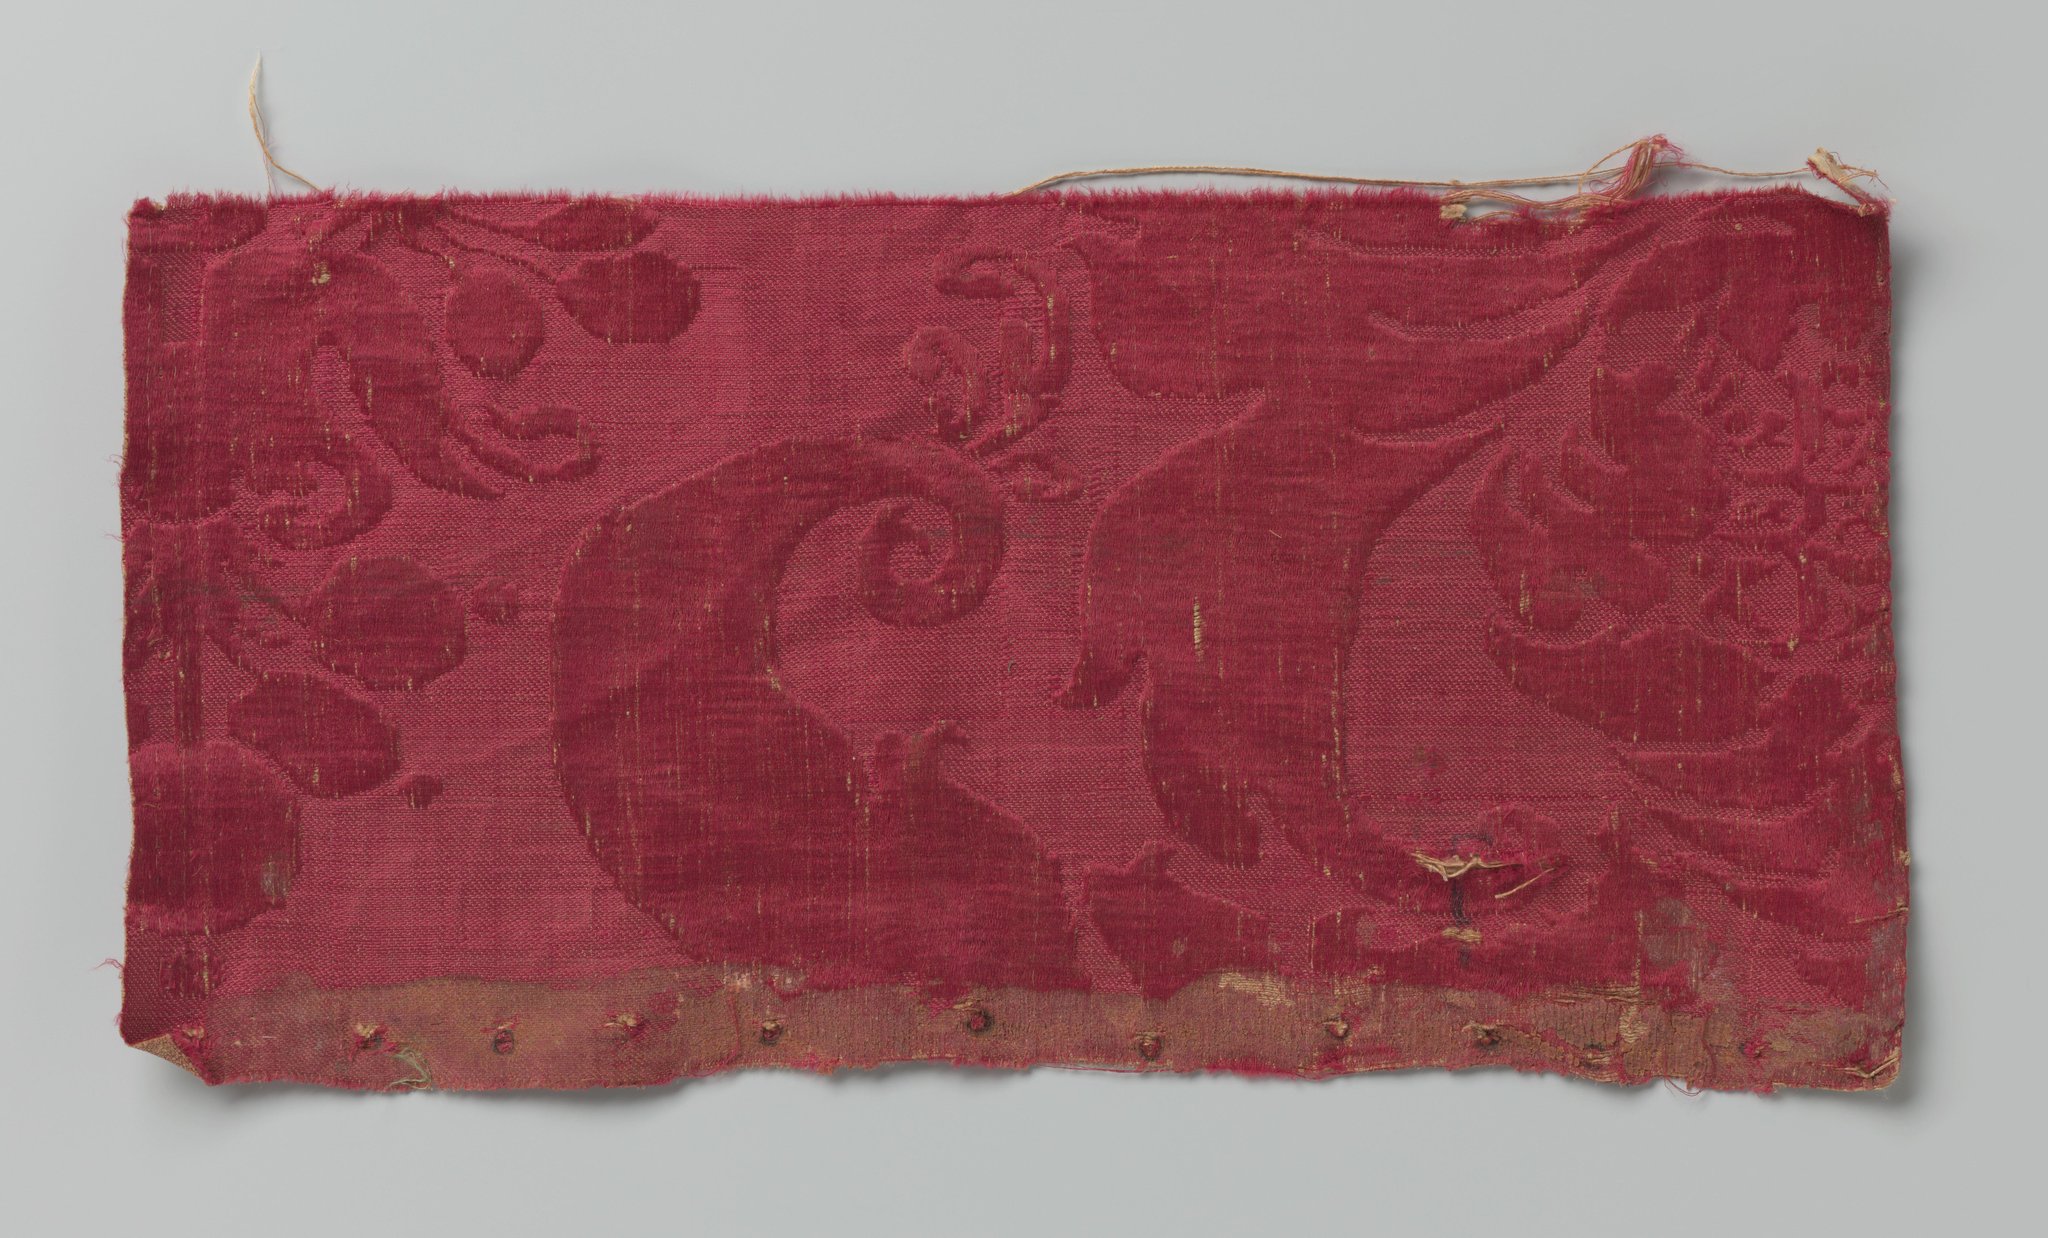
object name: upholstered wall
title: Wandbespanning van cerise-rode halfzijden damast in zes verschillende florale patronen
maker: Anonymous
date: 1700-1725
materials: linen, silk, wool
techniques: damask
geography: france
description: Fragmenten wandbespanning van cerise-rode halfzijden damast bestaande uit zes verschillende florale patronen. Ketting van rode en gele zijde, inslag (niet zichtbaar) van linnen.